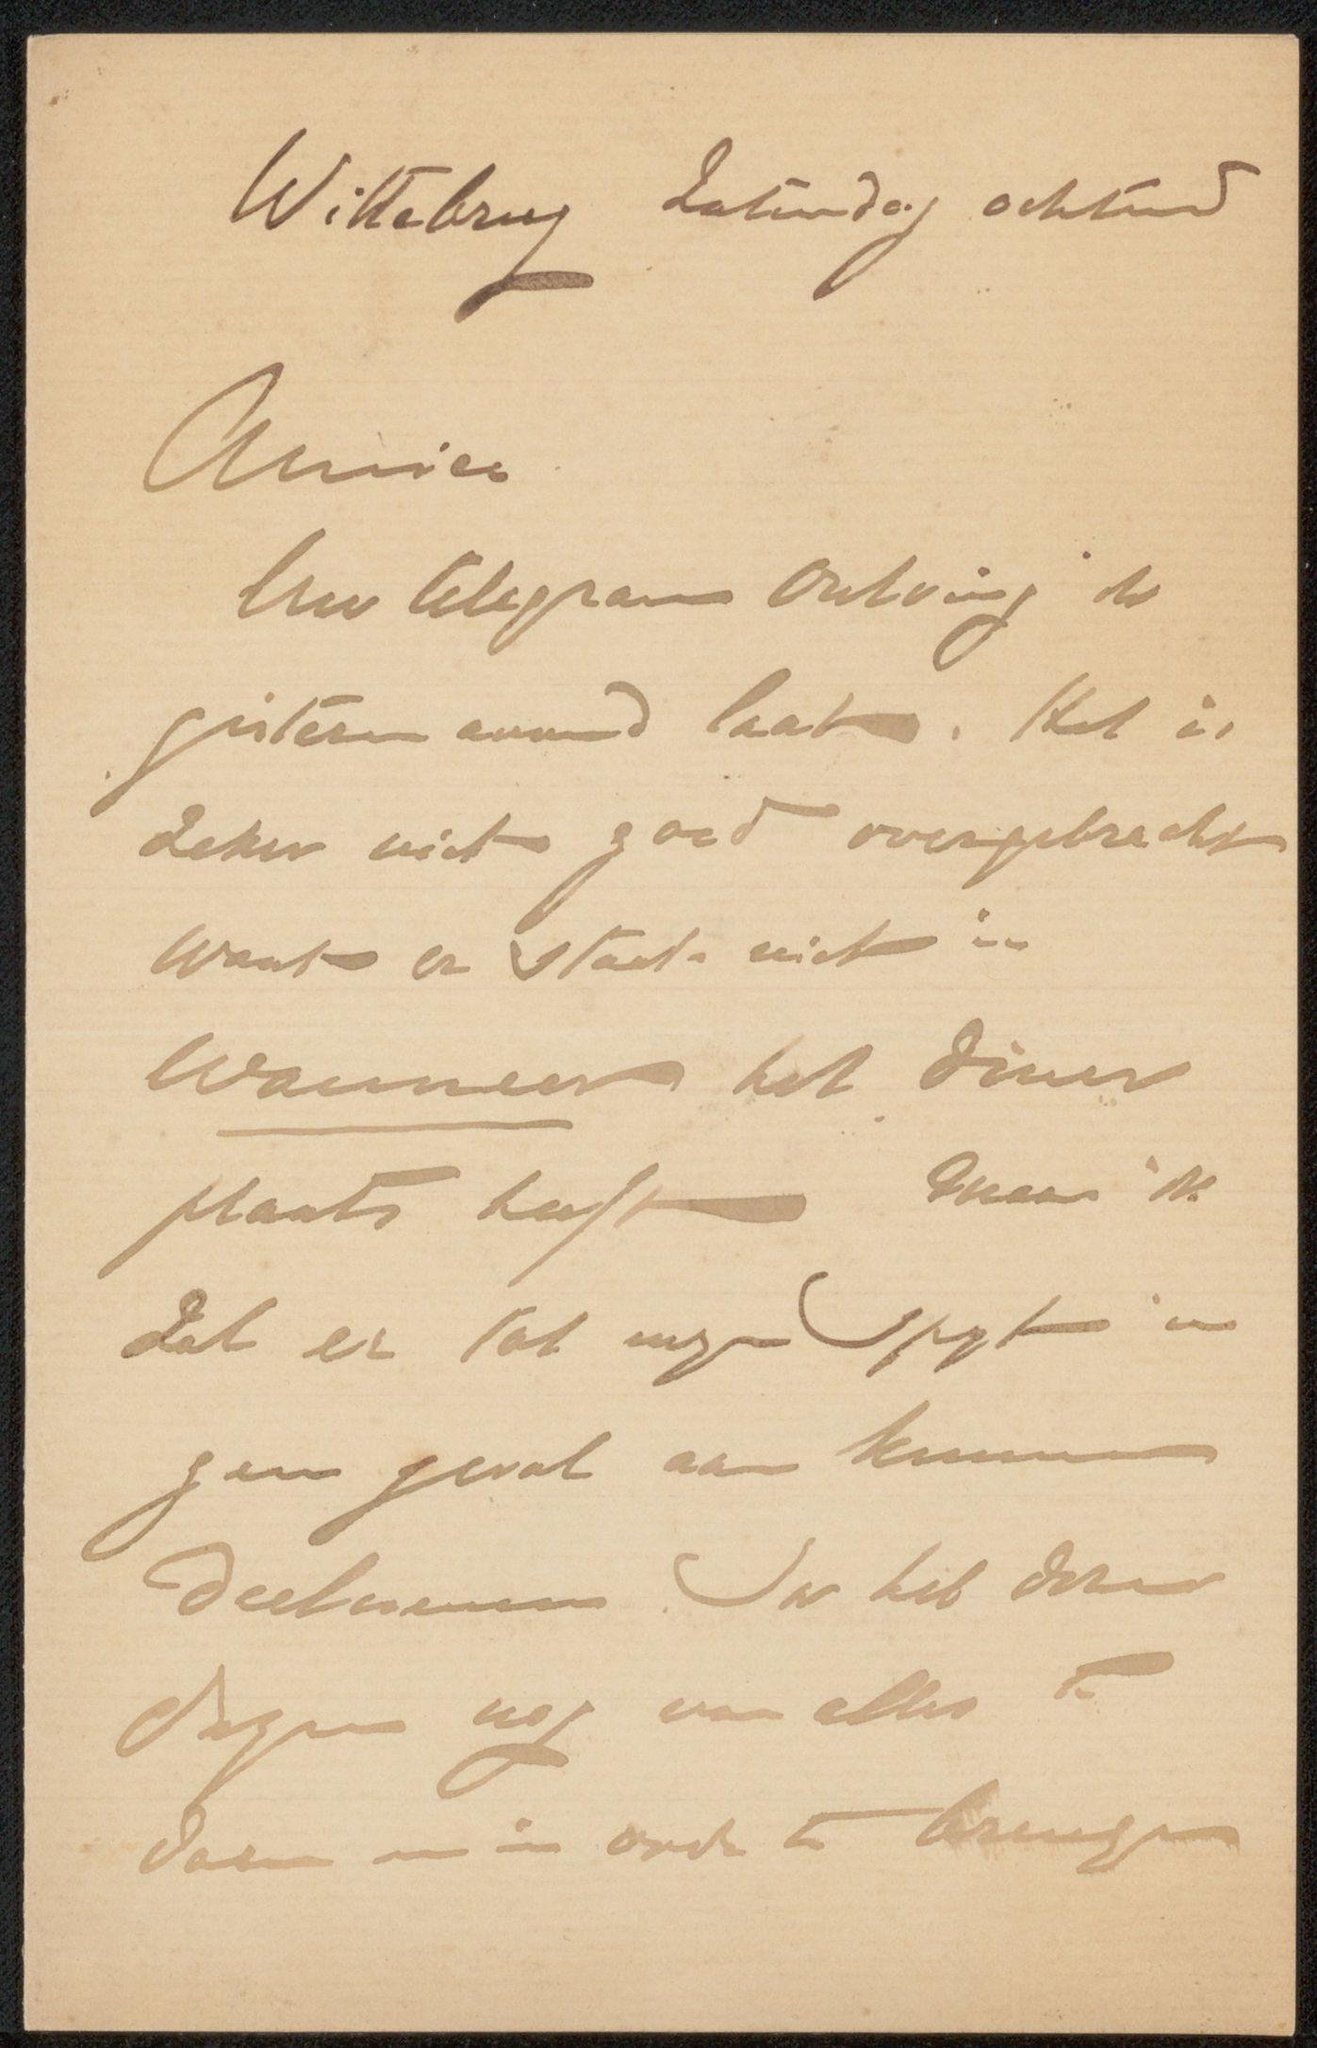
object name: letter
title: Brief aan Philip Zilcken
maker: carel nicolaas storm van s-gravesande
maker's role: draughtsman, print maker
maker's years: 1841-1924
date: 1851-1924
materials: ink, paper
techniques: pen, writing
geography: the hague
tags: painter, philip zilcken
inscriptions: collector's mark: ‘RPK’, watermark